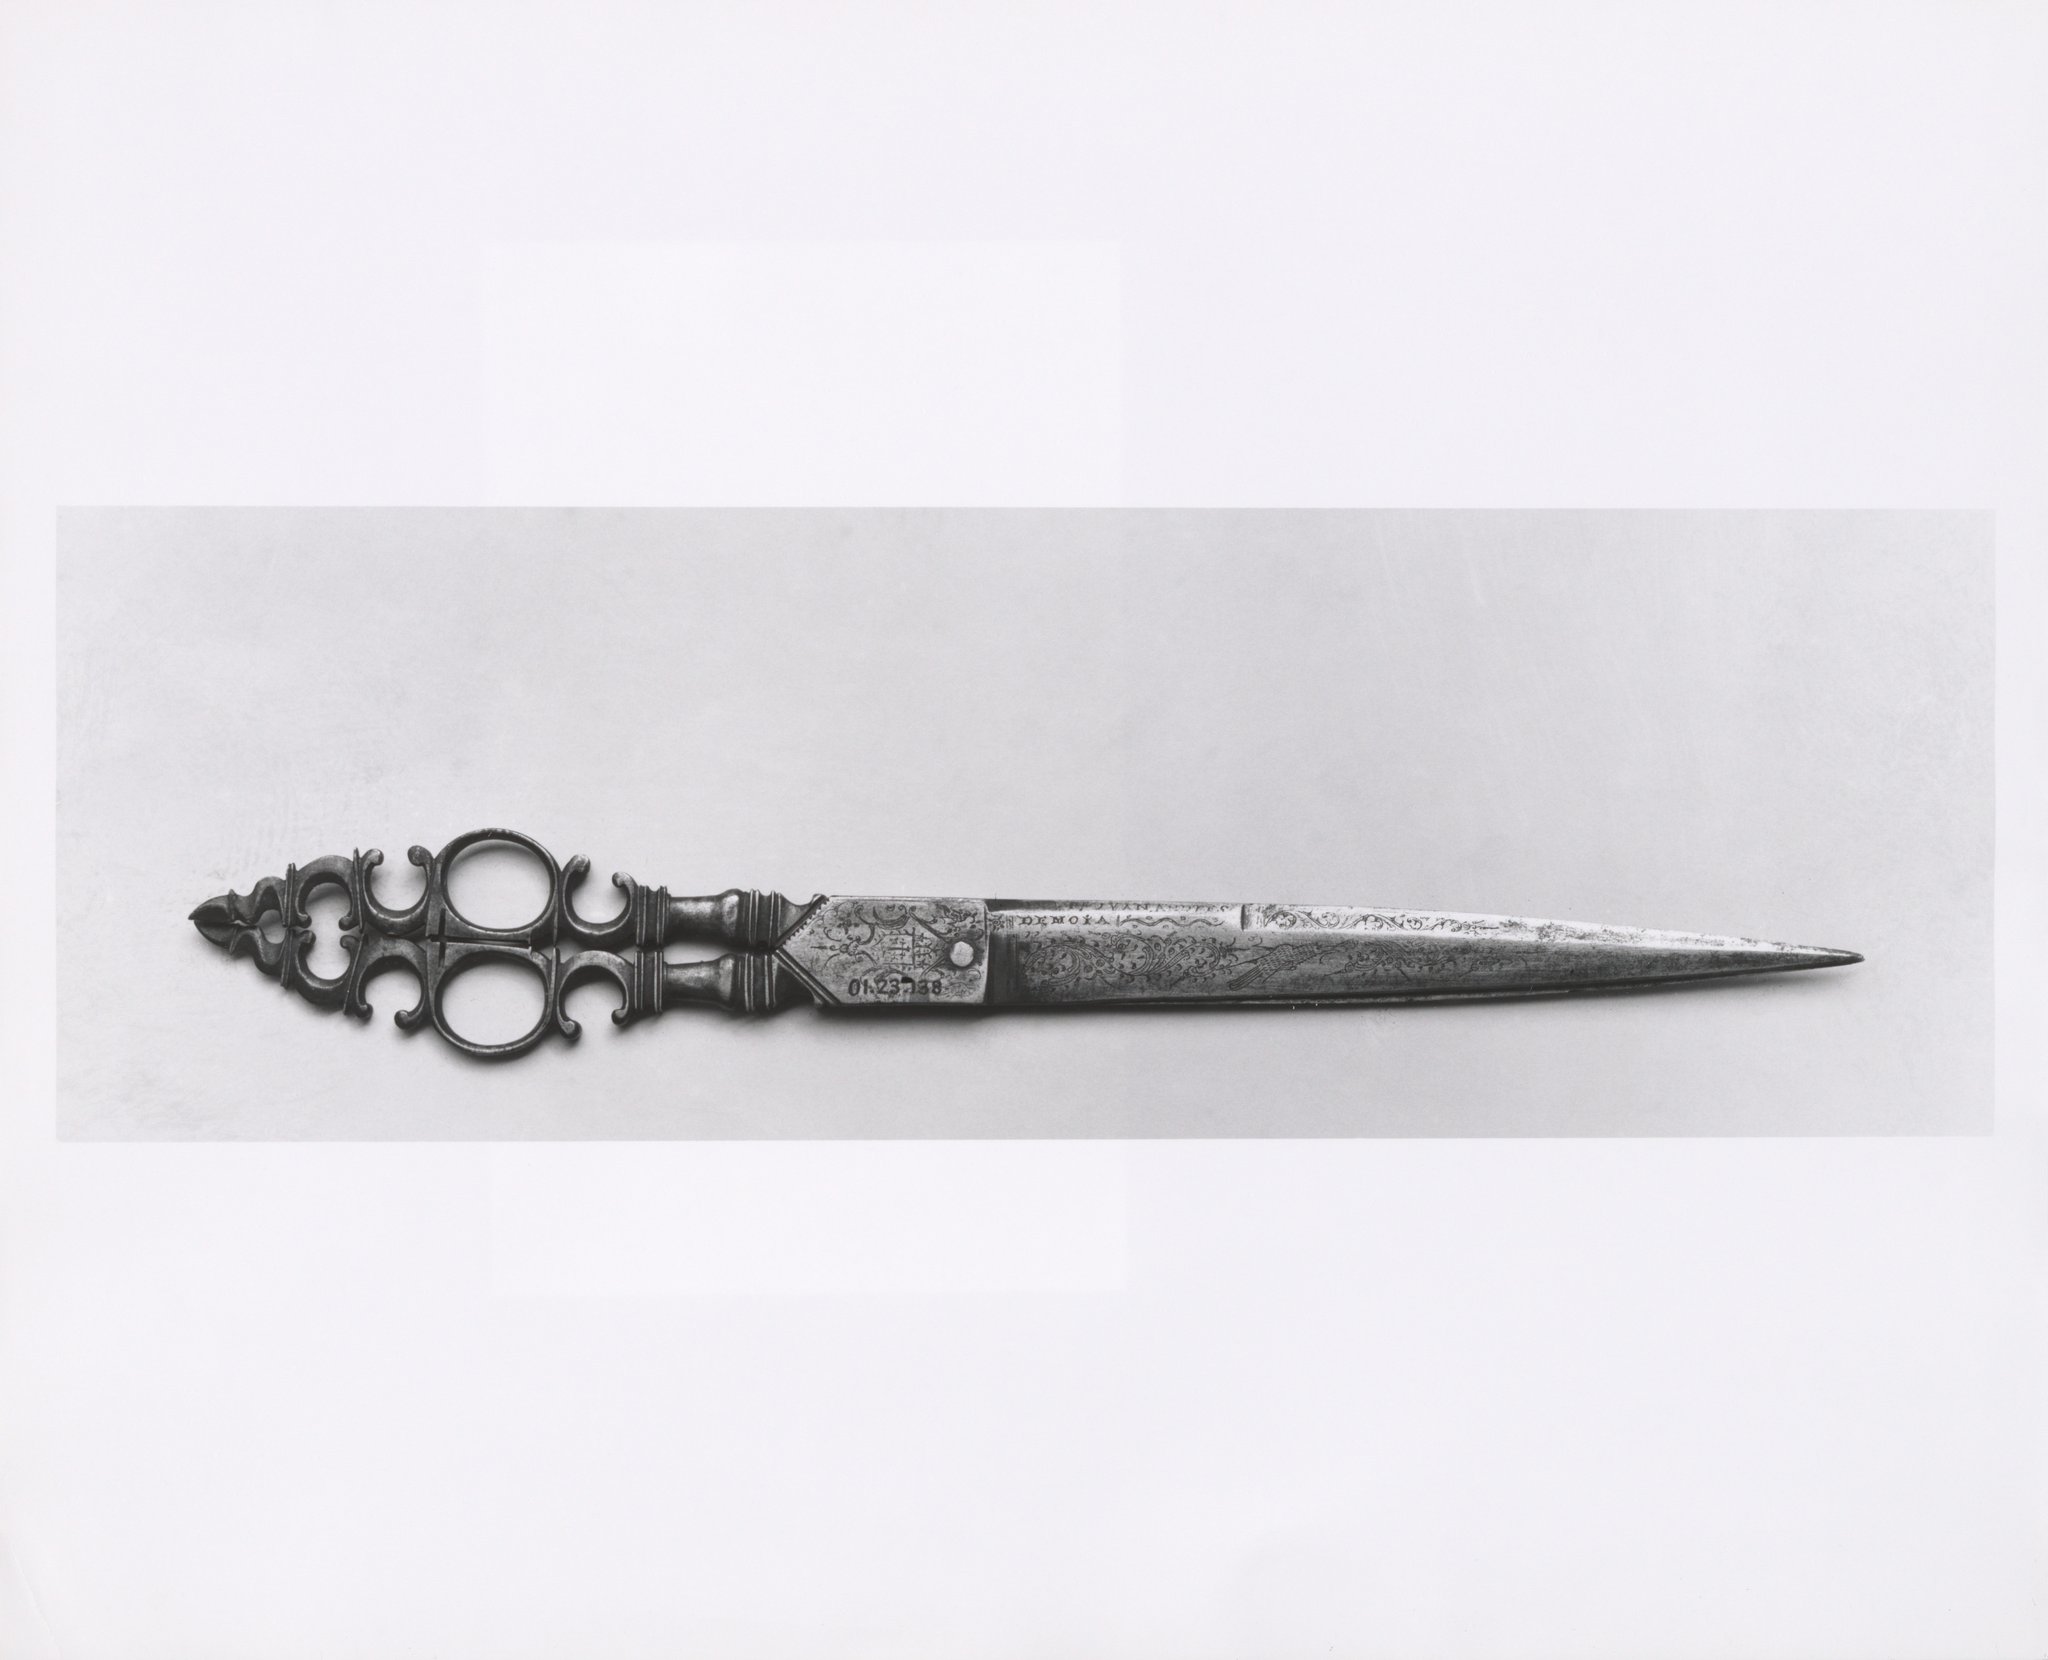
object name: scissors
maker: pedro diaz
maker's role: maker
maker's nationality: spanish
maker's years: 1700-1800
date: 1738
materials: steel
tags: coat of arms